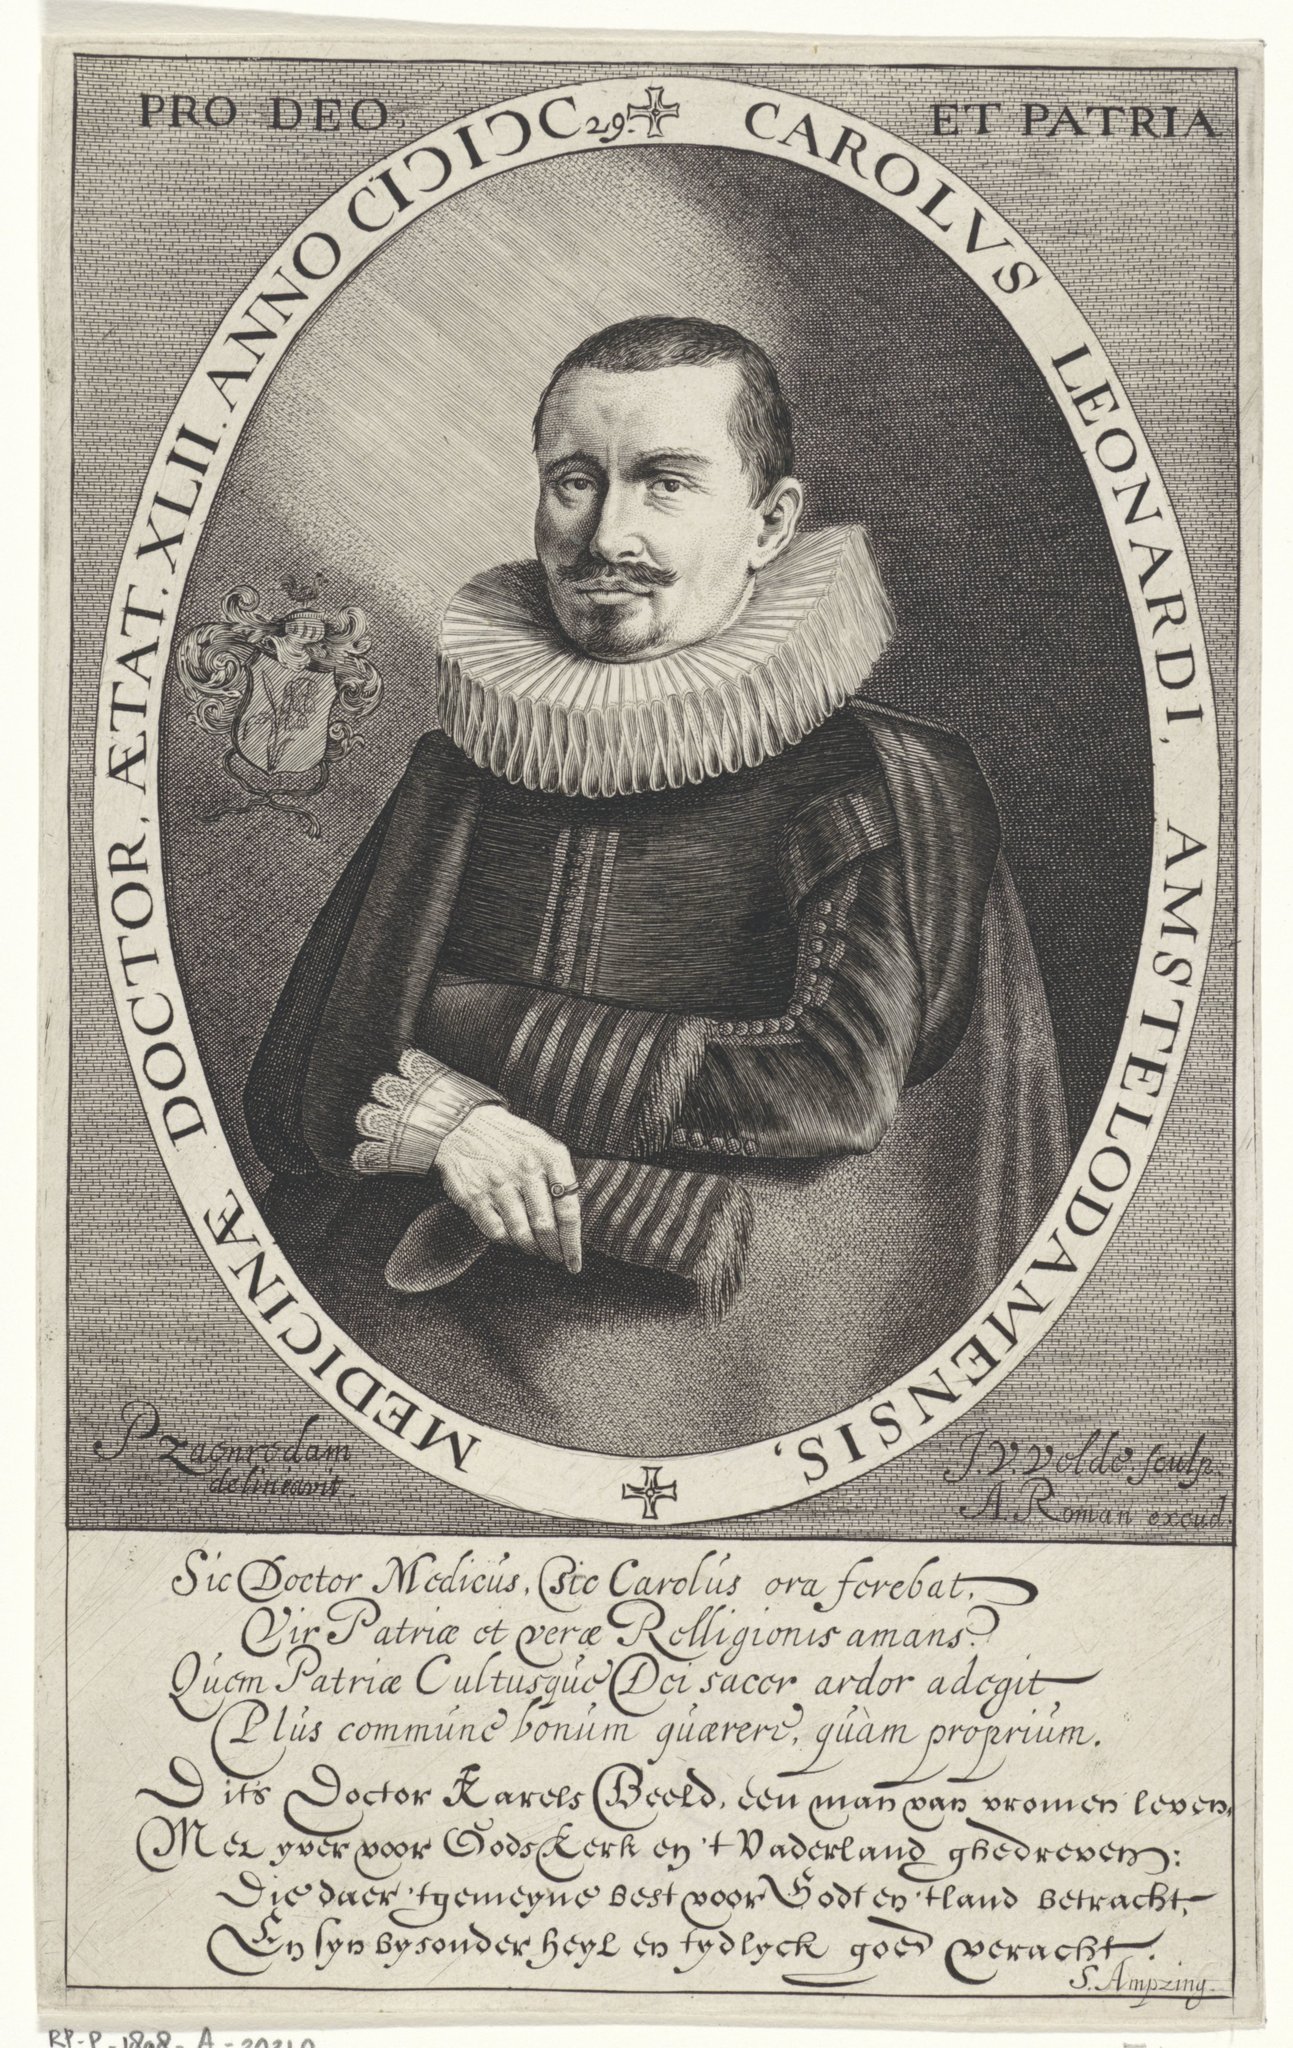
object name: print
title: Portret van Carolus Leonardi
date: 1629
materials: paper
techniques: engraving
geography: haarlem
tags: medicus, carolus leonardi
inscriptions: collector's mark: Lugt 964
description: Portret van Carolus Leonardi, medicus te Amsterdam.